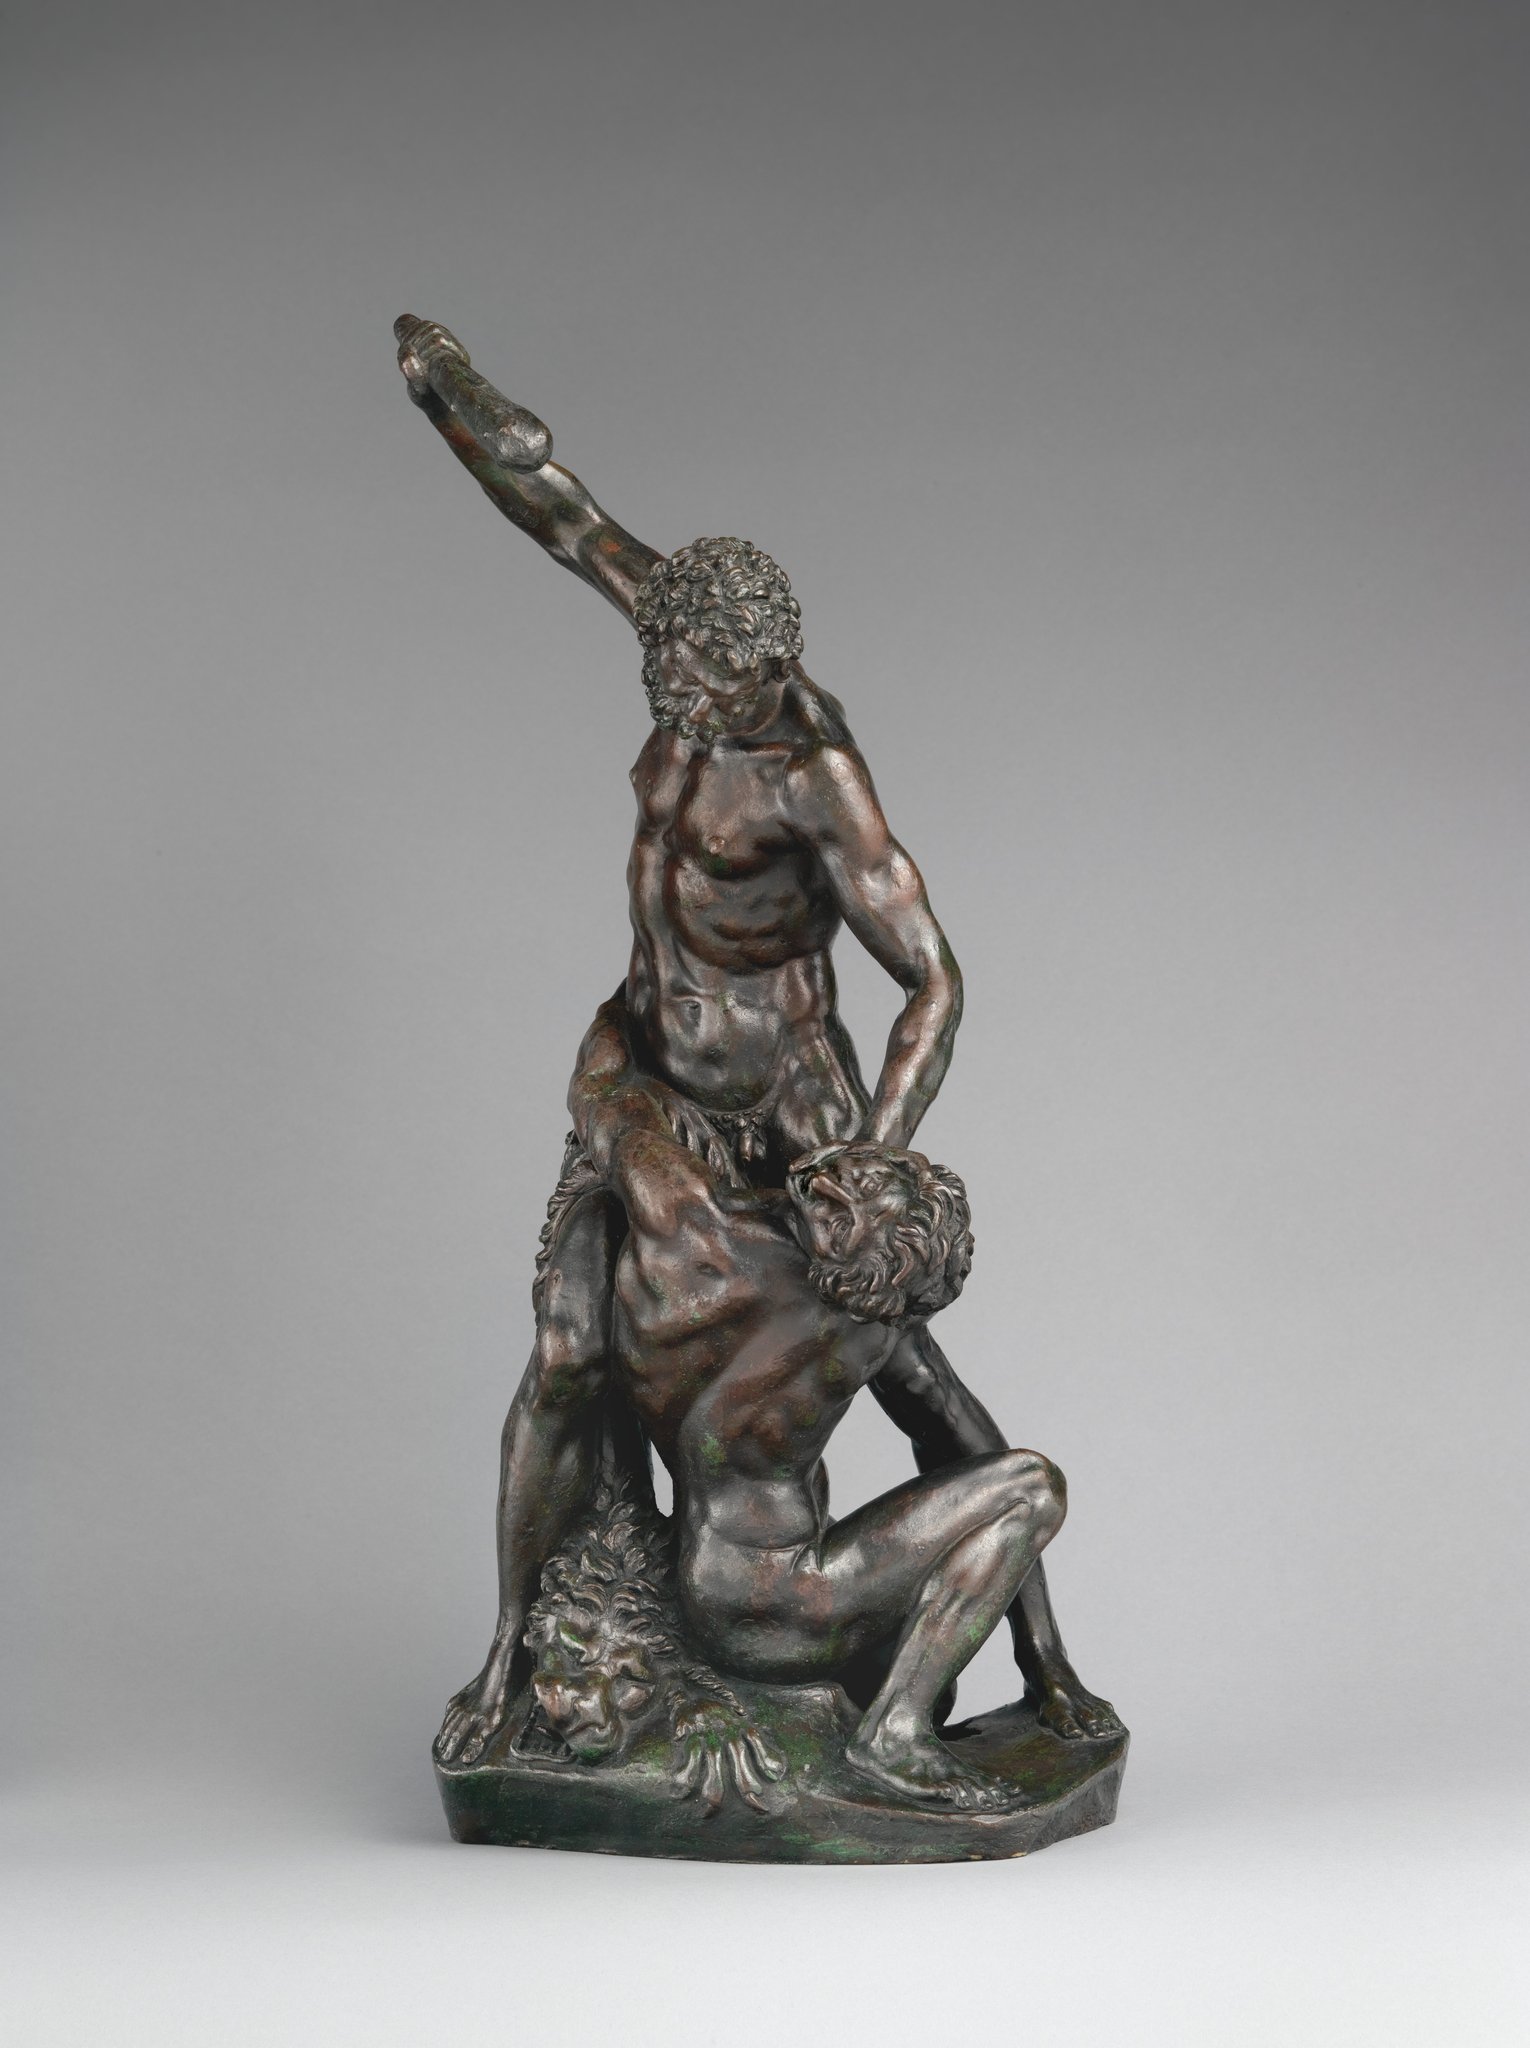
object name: statuette group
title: Hercules and Cacus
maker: michelangelo buonarroti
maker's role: artist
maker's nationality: italian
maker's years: 1475-1564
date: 1801-1900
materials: bronze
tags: hercules